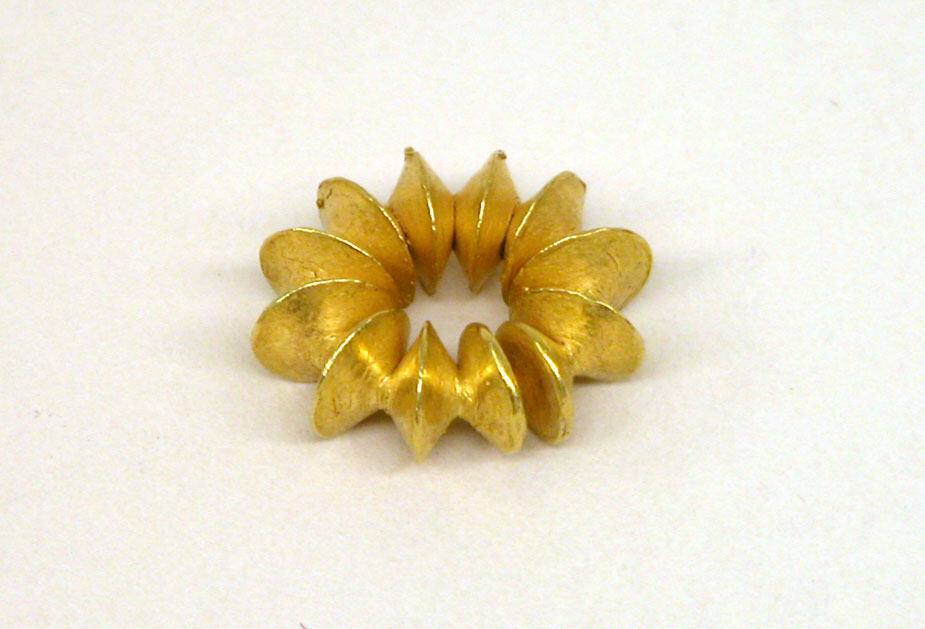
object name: ear clip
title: Ear Clip Composed of Fused Discs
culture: indonesian, javanese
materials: gold